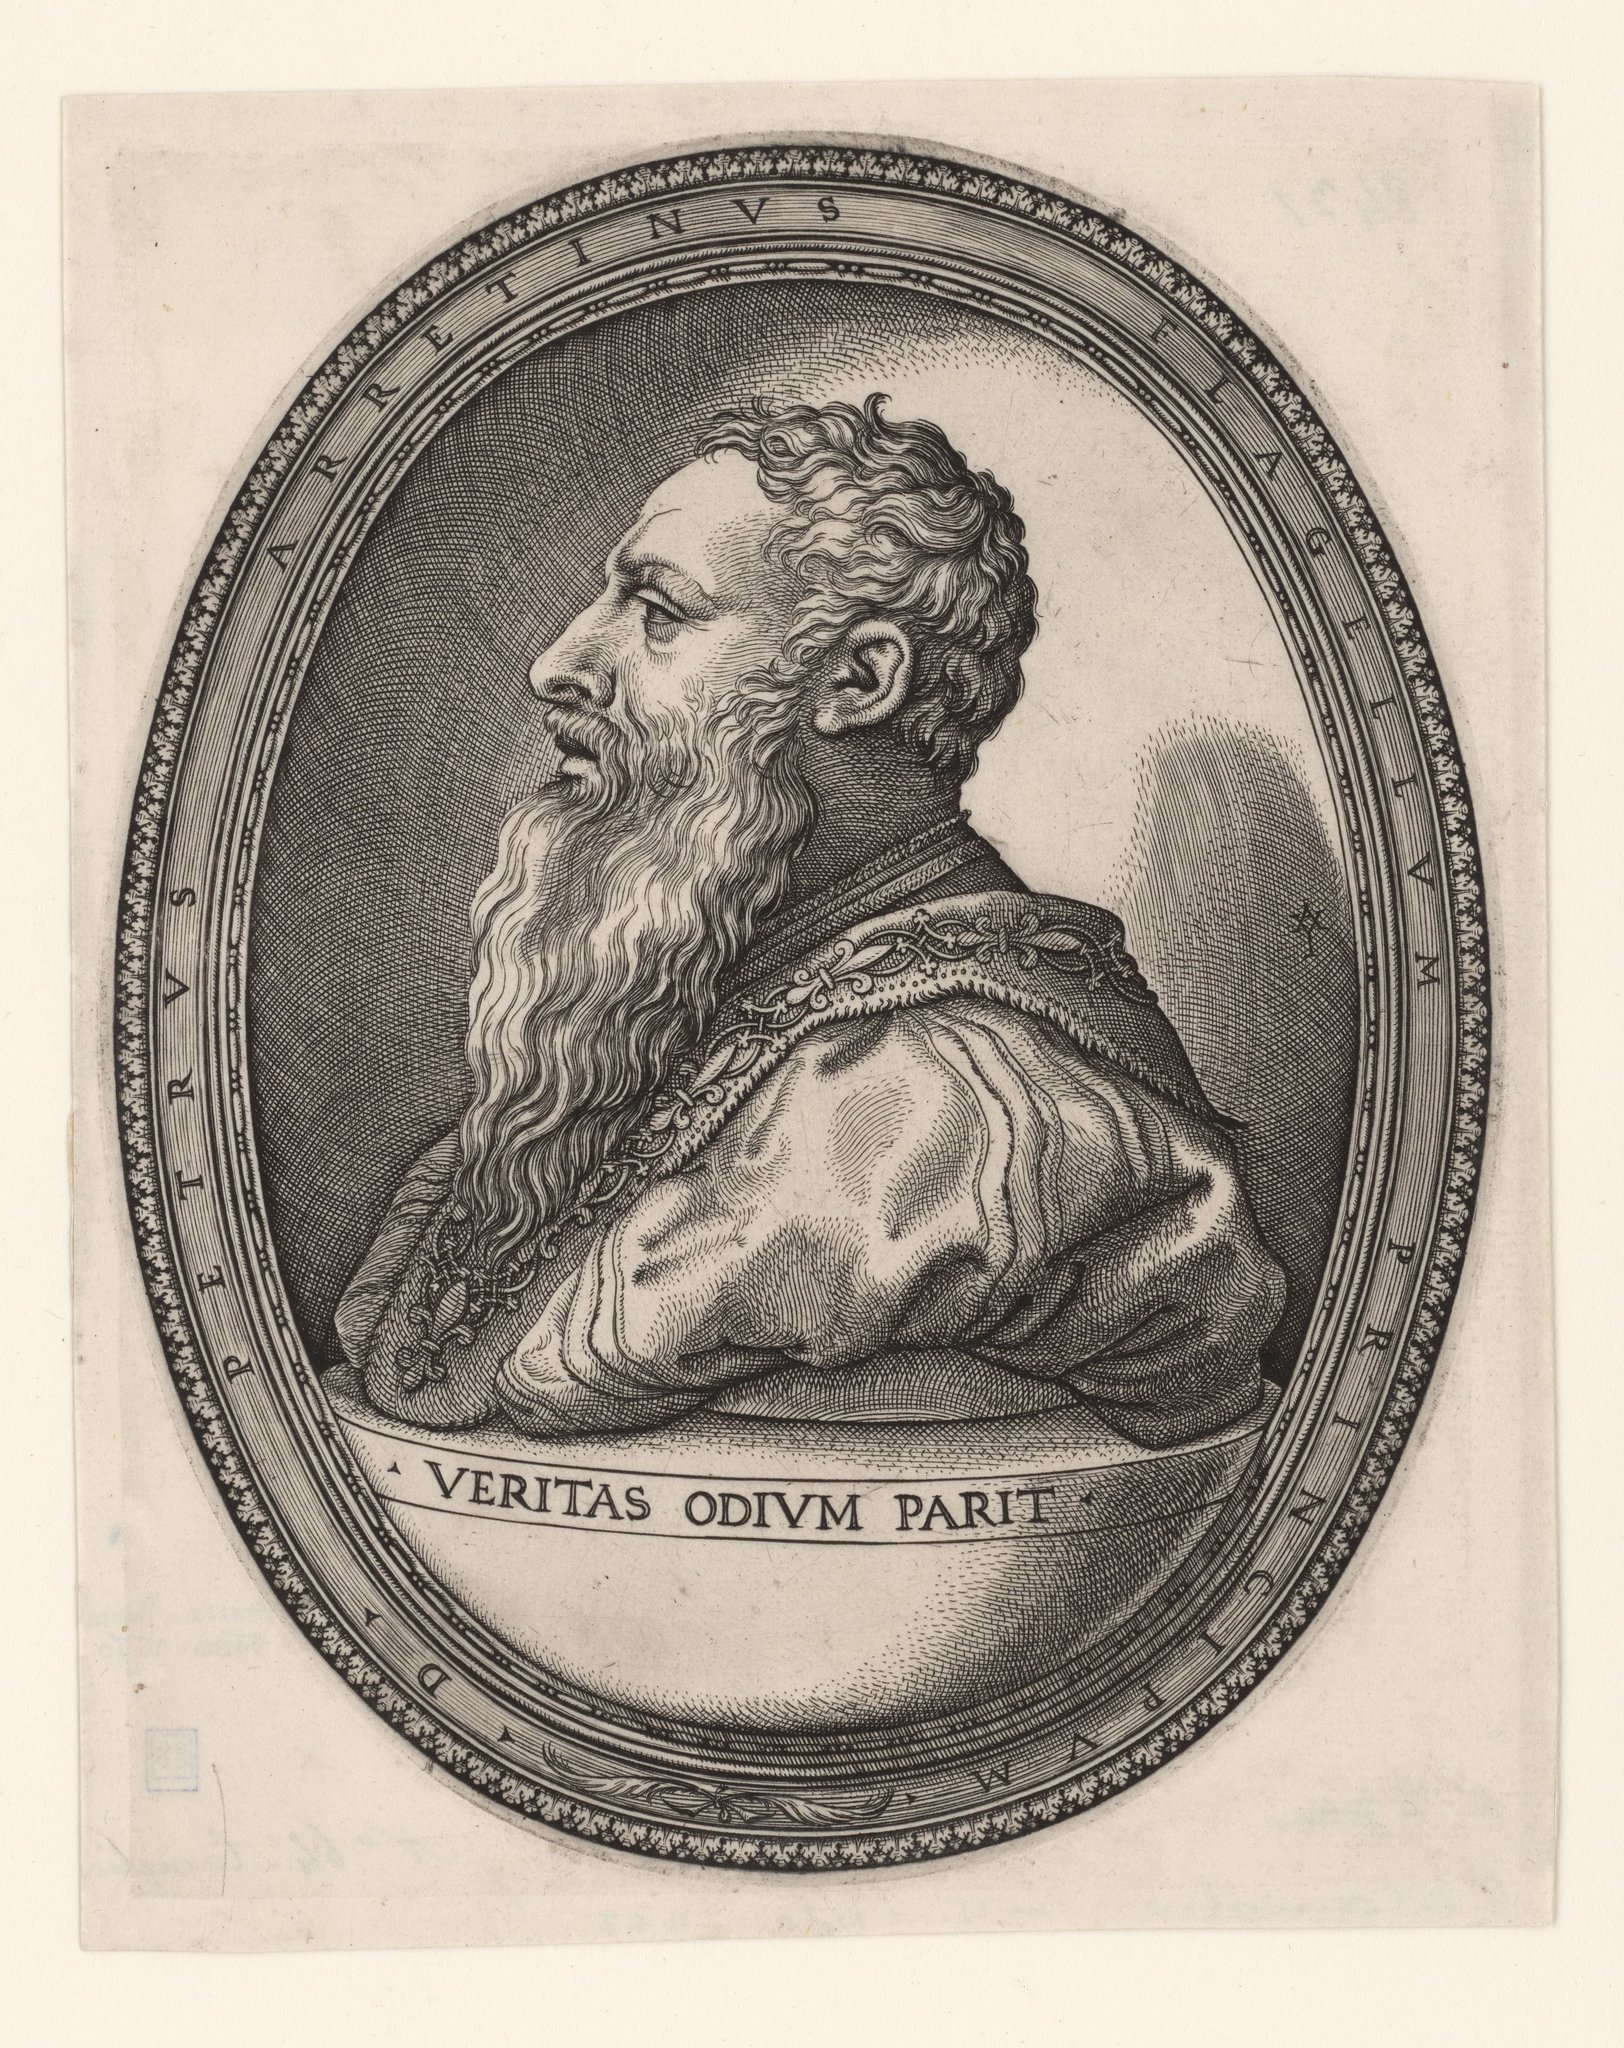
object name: print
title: Portret van dichter Pietro Aretino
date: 1515-1565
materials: paper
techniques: engraving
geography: italy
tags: historical persons, portrait of a writer, writer, poet, author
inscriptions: collector's mark: Lugt 4191, collector's mark: Lugt 2228, collector's mark: Lugt 2760